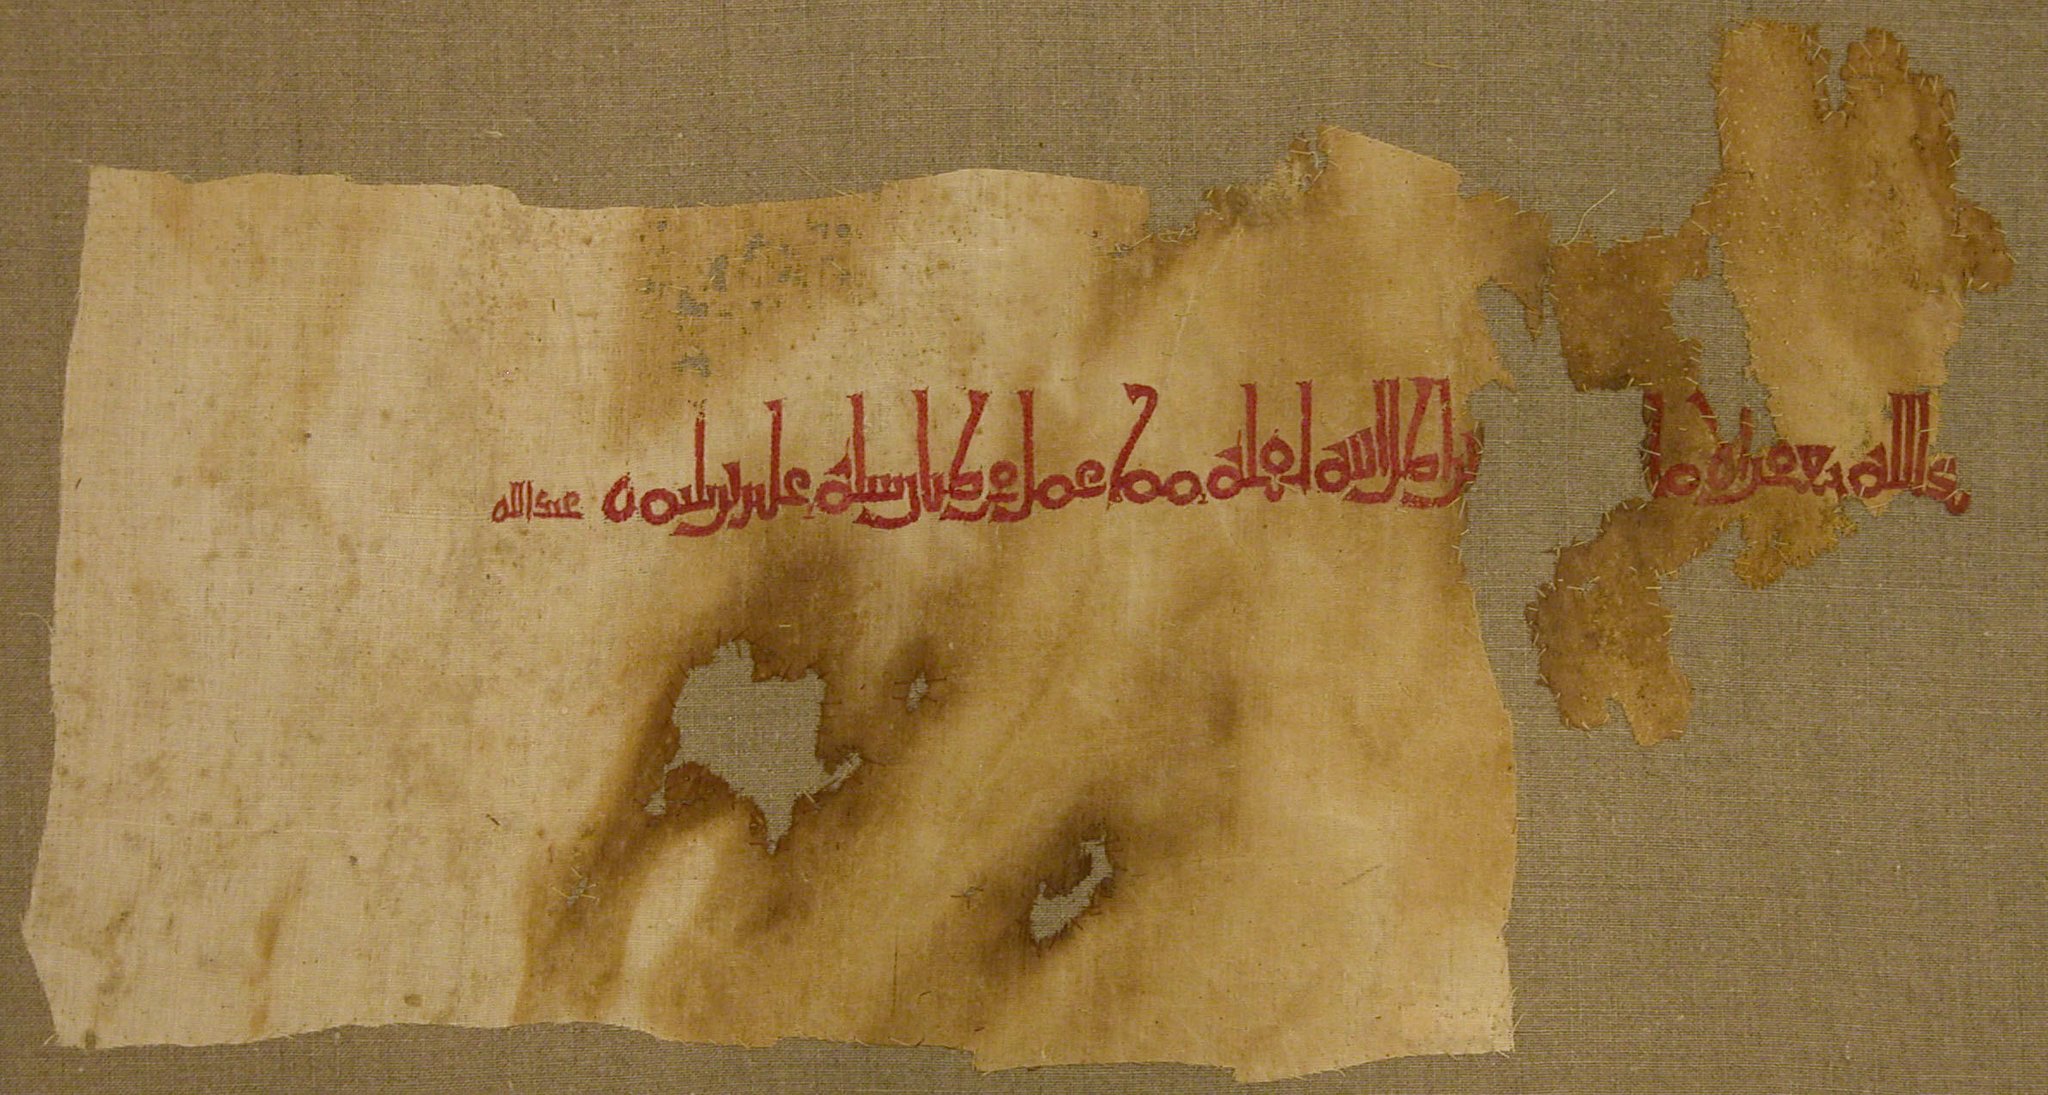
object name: textile fragment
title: Tiraz Textile Fragment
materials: linen, silk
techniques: embroidery, weave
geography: iraq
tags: arabic